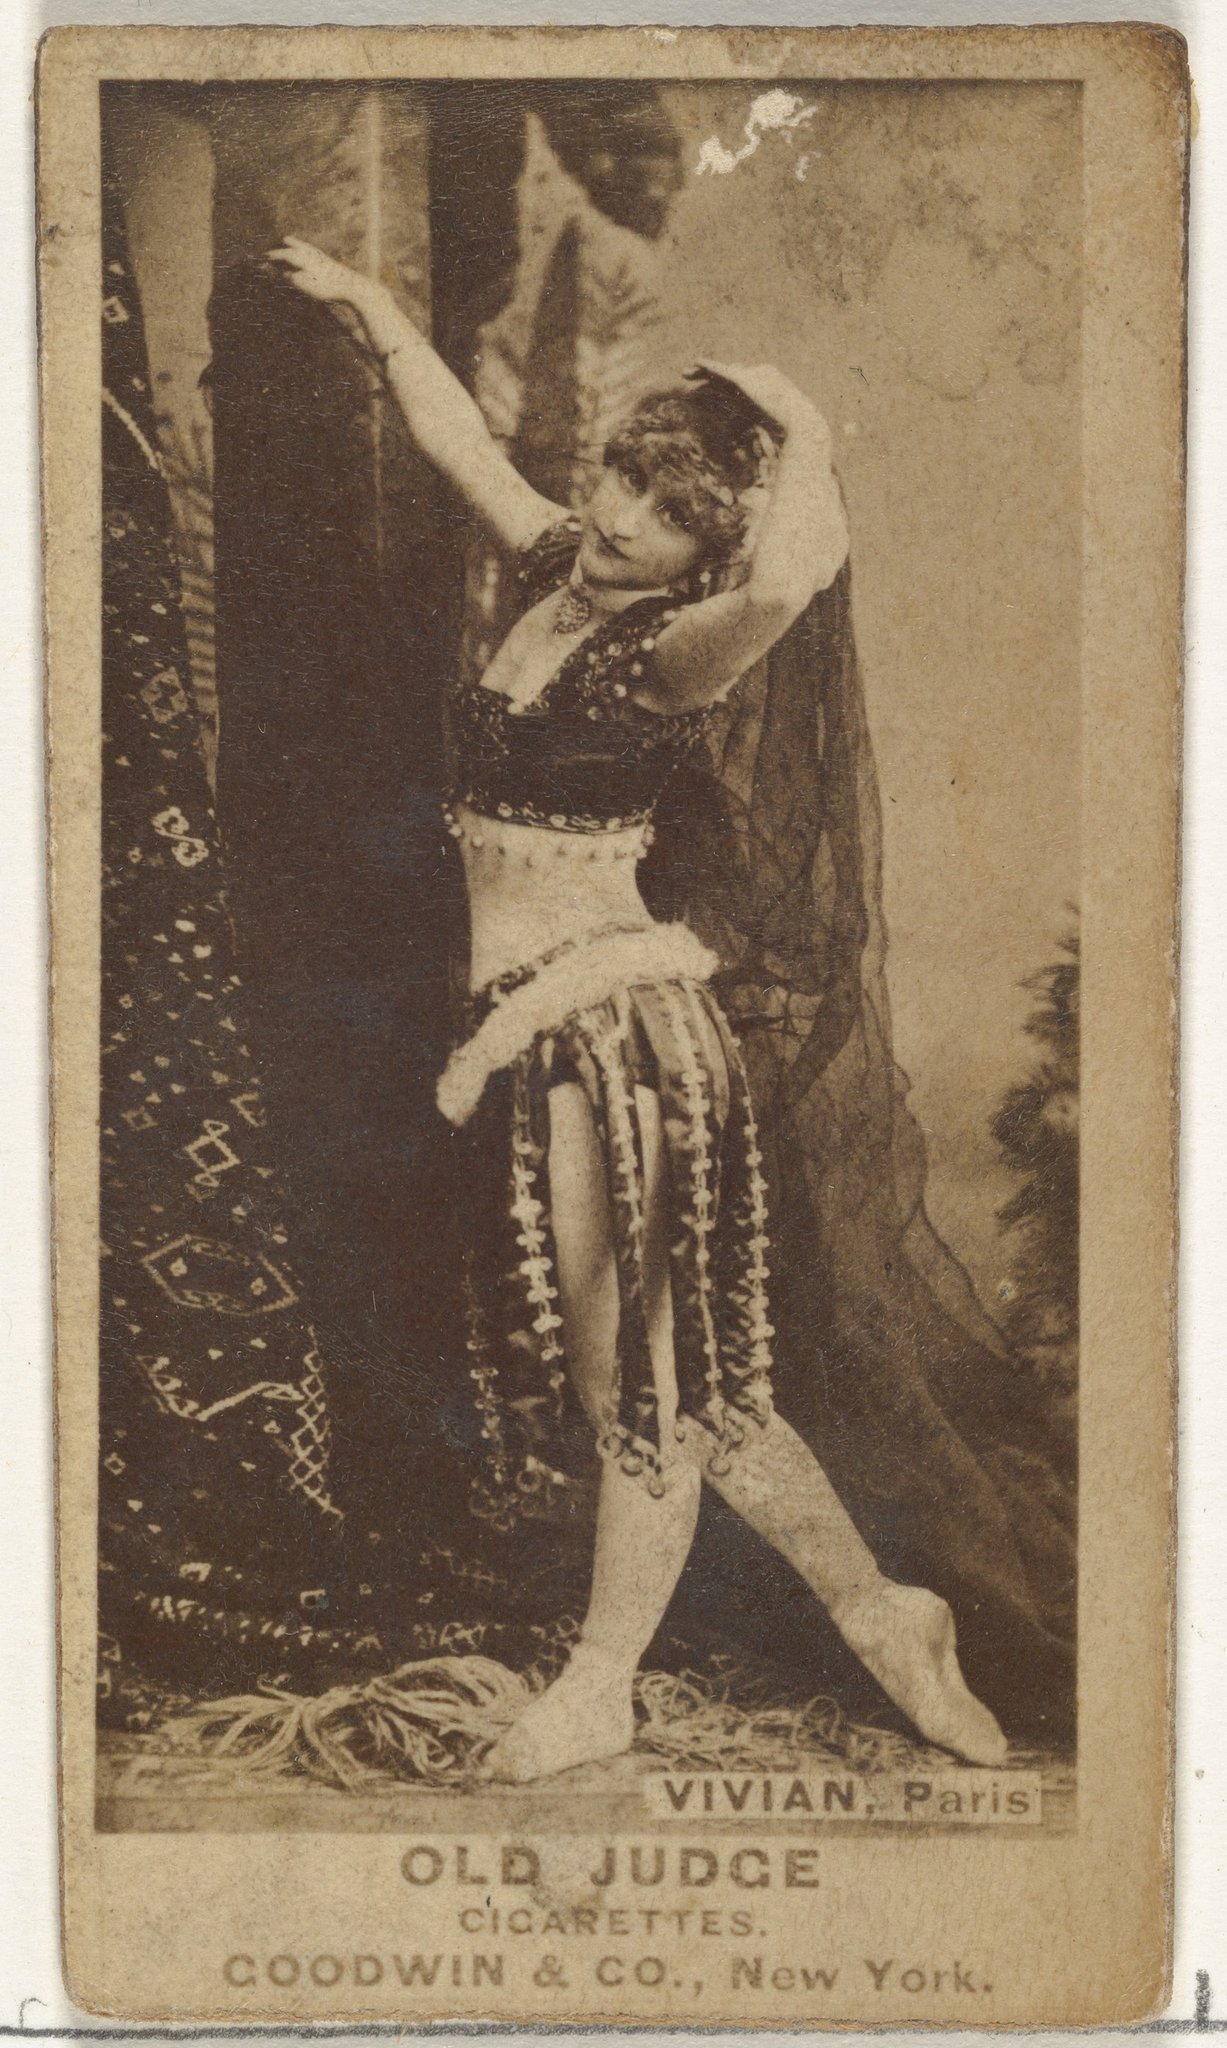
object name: photograph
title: Mlle. Vivian, Paris, from the Actors and Actresses series (N171) for Old Judge Cigarettes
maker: goodwin & company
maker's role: publisher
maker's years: 1850-1950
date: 1886-1890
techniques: albumen silver print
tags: portraits,women,actresses